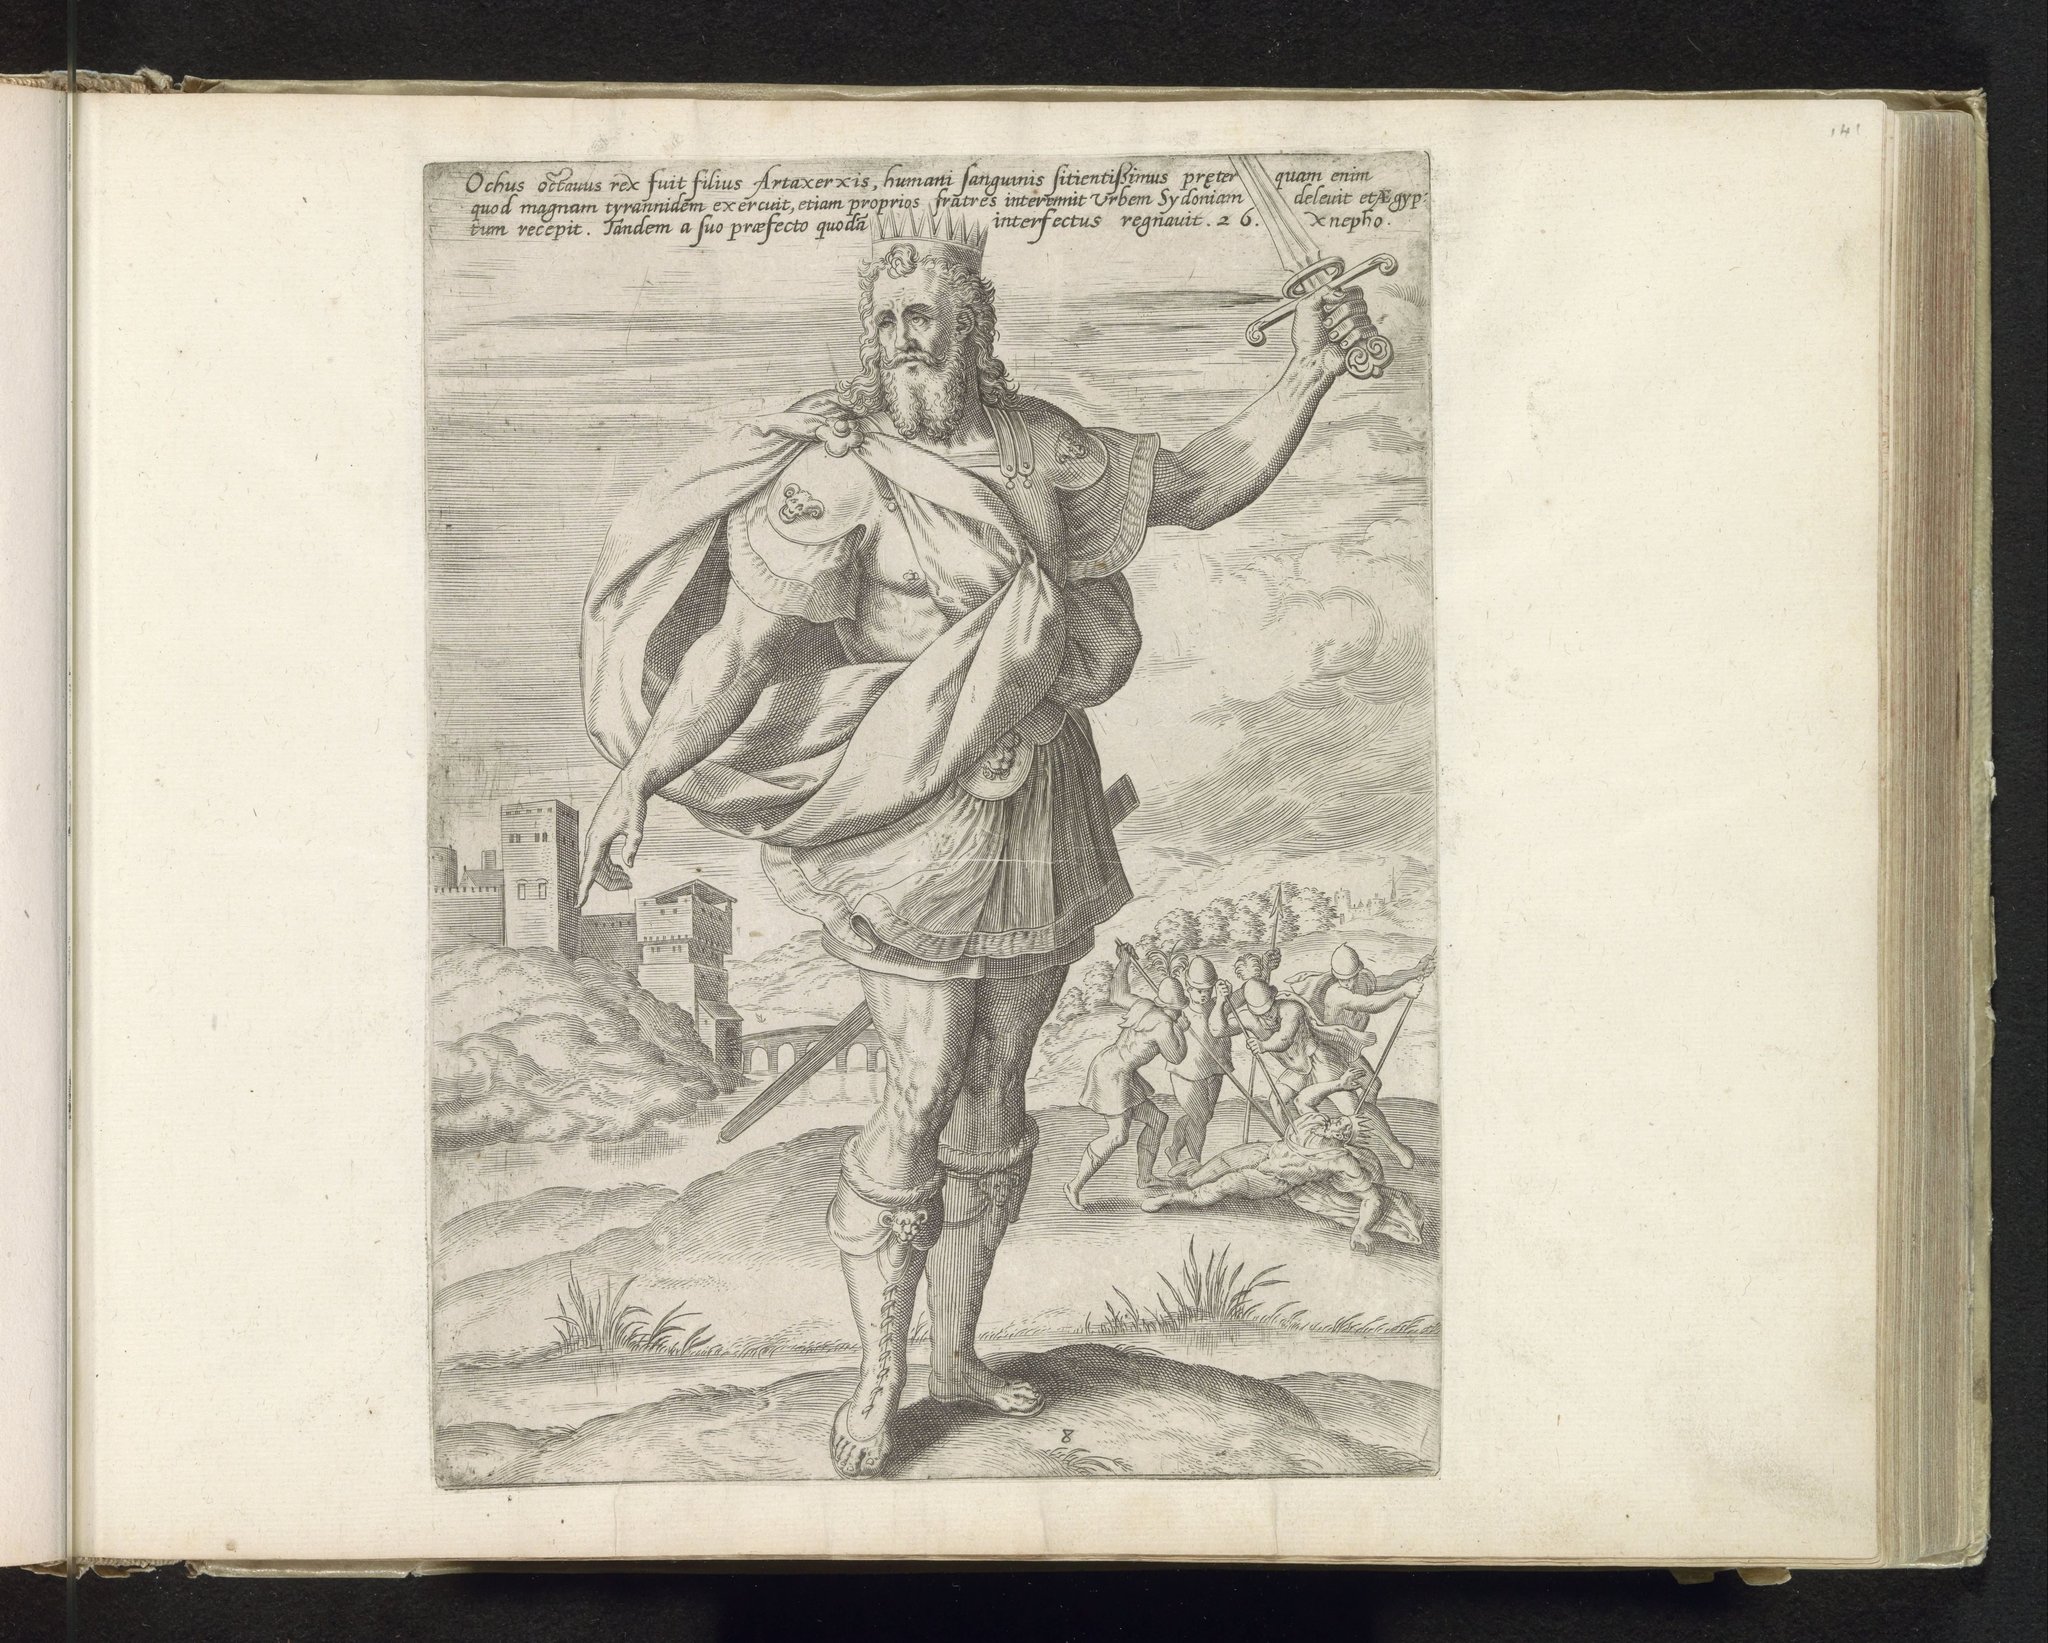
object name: album leaf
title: Perzische koningen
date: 1585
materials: paper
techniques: engraving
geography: antwerp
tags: murder, male persons from classical history, ruler, sovereign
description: Koning Artaxerxes III van Perzië staande met een zwaard in zijn hand. Op de achtergrond is vermoedelijk te zien hoe zijn oudere broer wordt geëxecuteerd. Boven de voorstelling een drieregelige tekst in het Latijn over onder andere zijn overwinningen op Egypte en de stad Sidon. Deze prent maakt deel uit van een album.